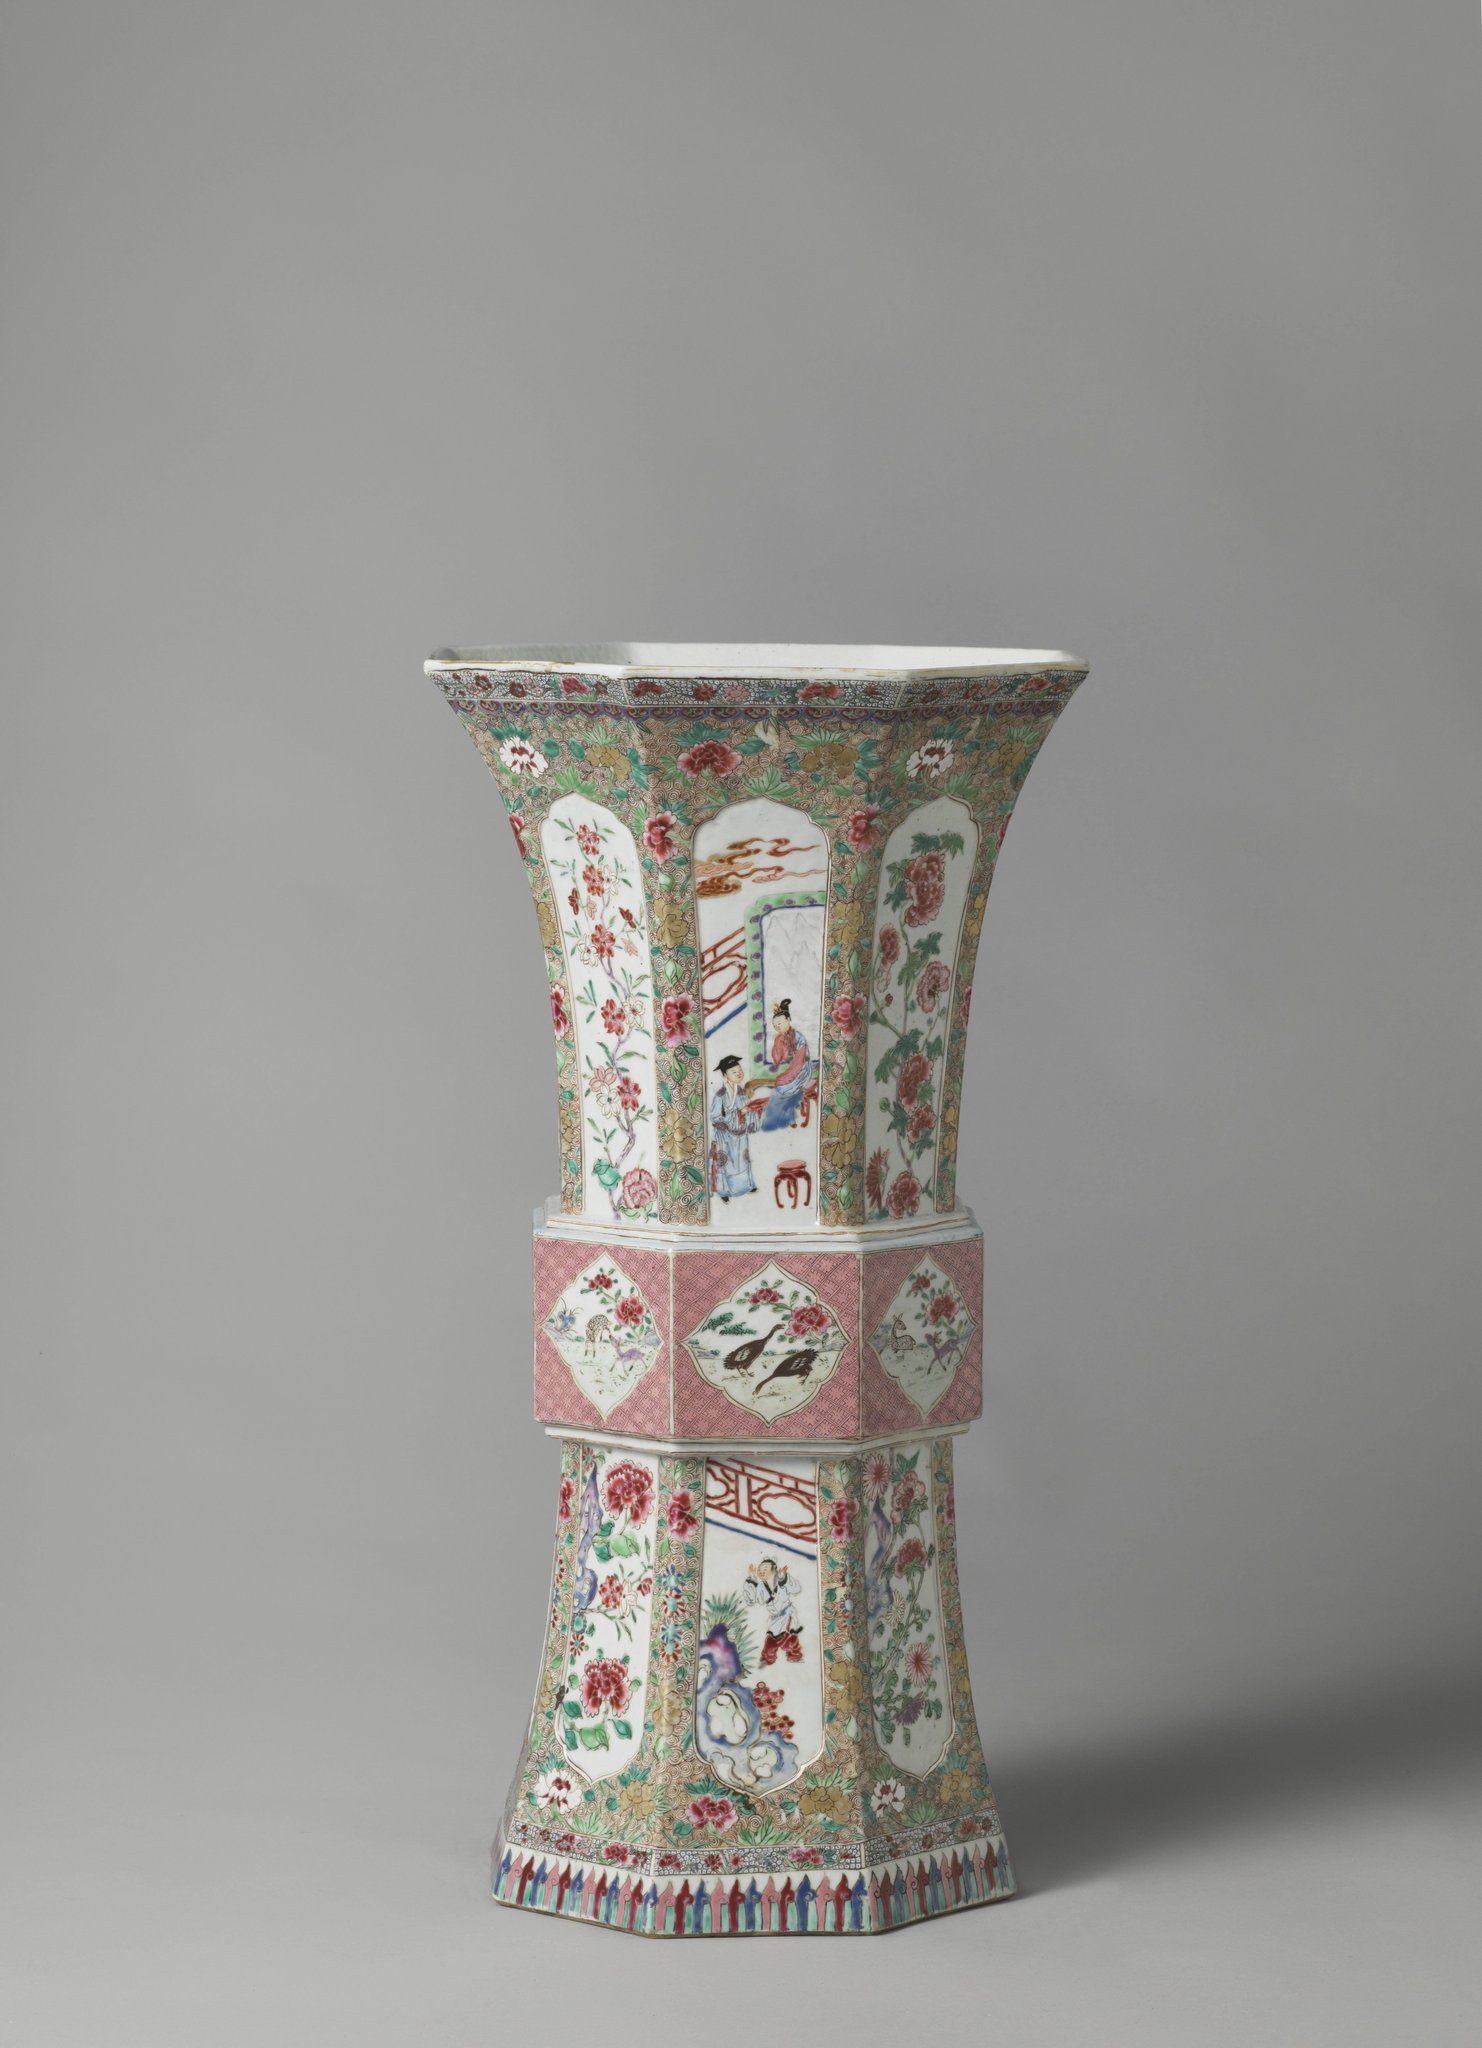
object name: vase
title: Octagonal, 'gu'-shaped beakervase with flowering plants and figures in a fenced garden in panels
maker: Anonymous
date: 1800-1899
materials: glaze, gold, paint, porcelain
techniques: firing, gilding, turning, vitrification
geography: china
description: When the fashion for lavishly decorating interiors with porcelain arose around 1700, so-called garnitures were designed in sets of five or sometimes seven lidded jars and trumpet vases. They were used as display pieces on mantels or cabinets, but this later, large set served as decoration in a fireplace when it was not in use during the summer.